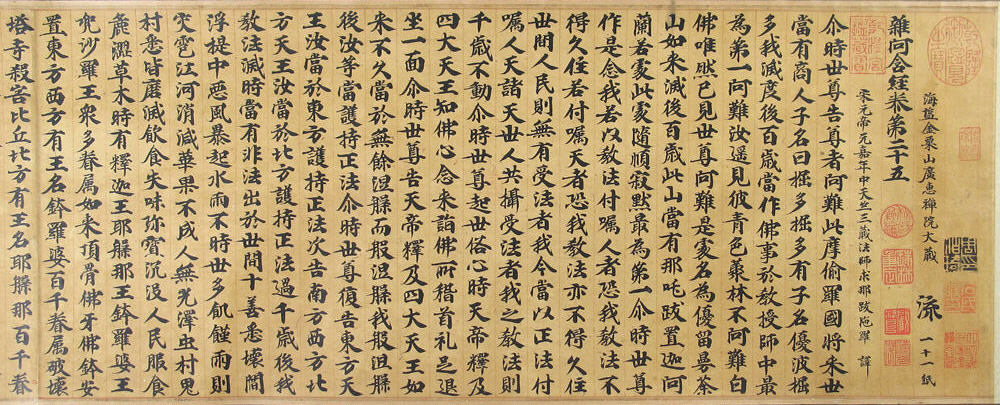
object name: handscroll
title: Samyutagama Sutra, chapter 25, from the Jinsushan Tripitaka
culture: chinese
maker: unidentified artist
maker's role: artist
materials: ink, paper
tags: calligraphy